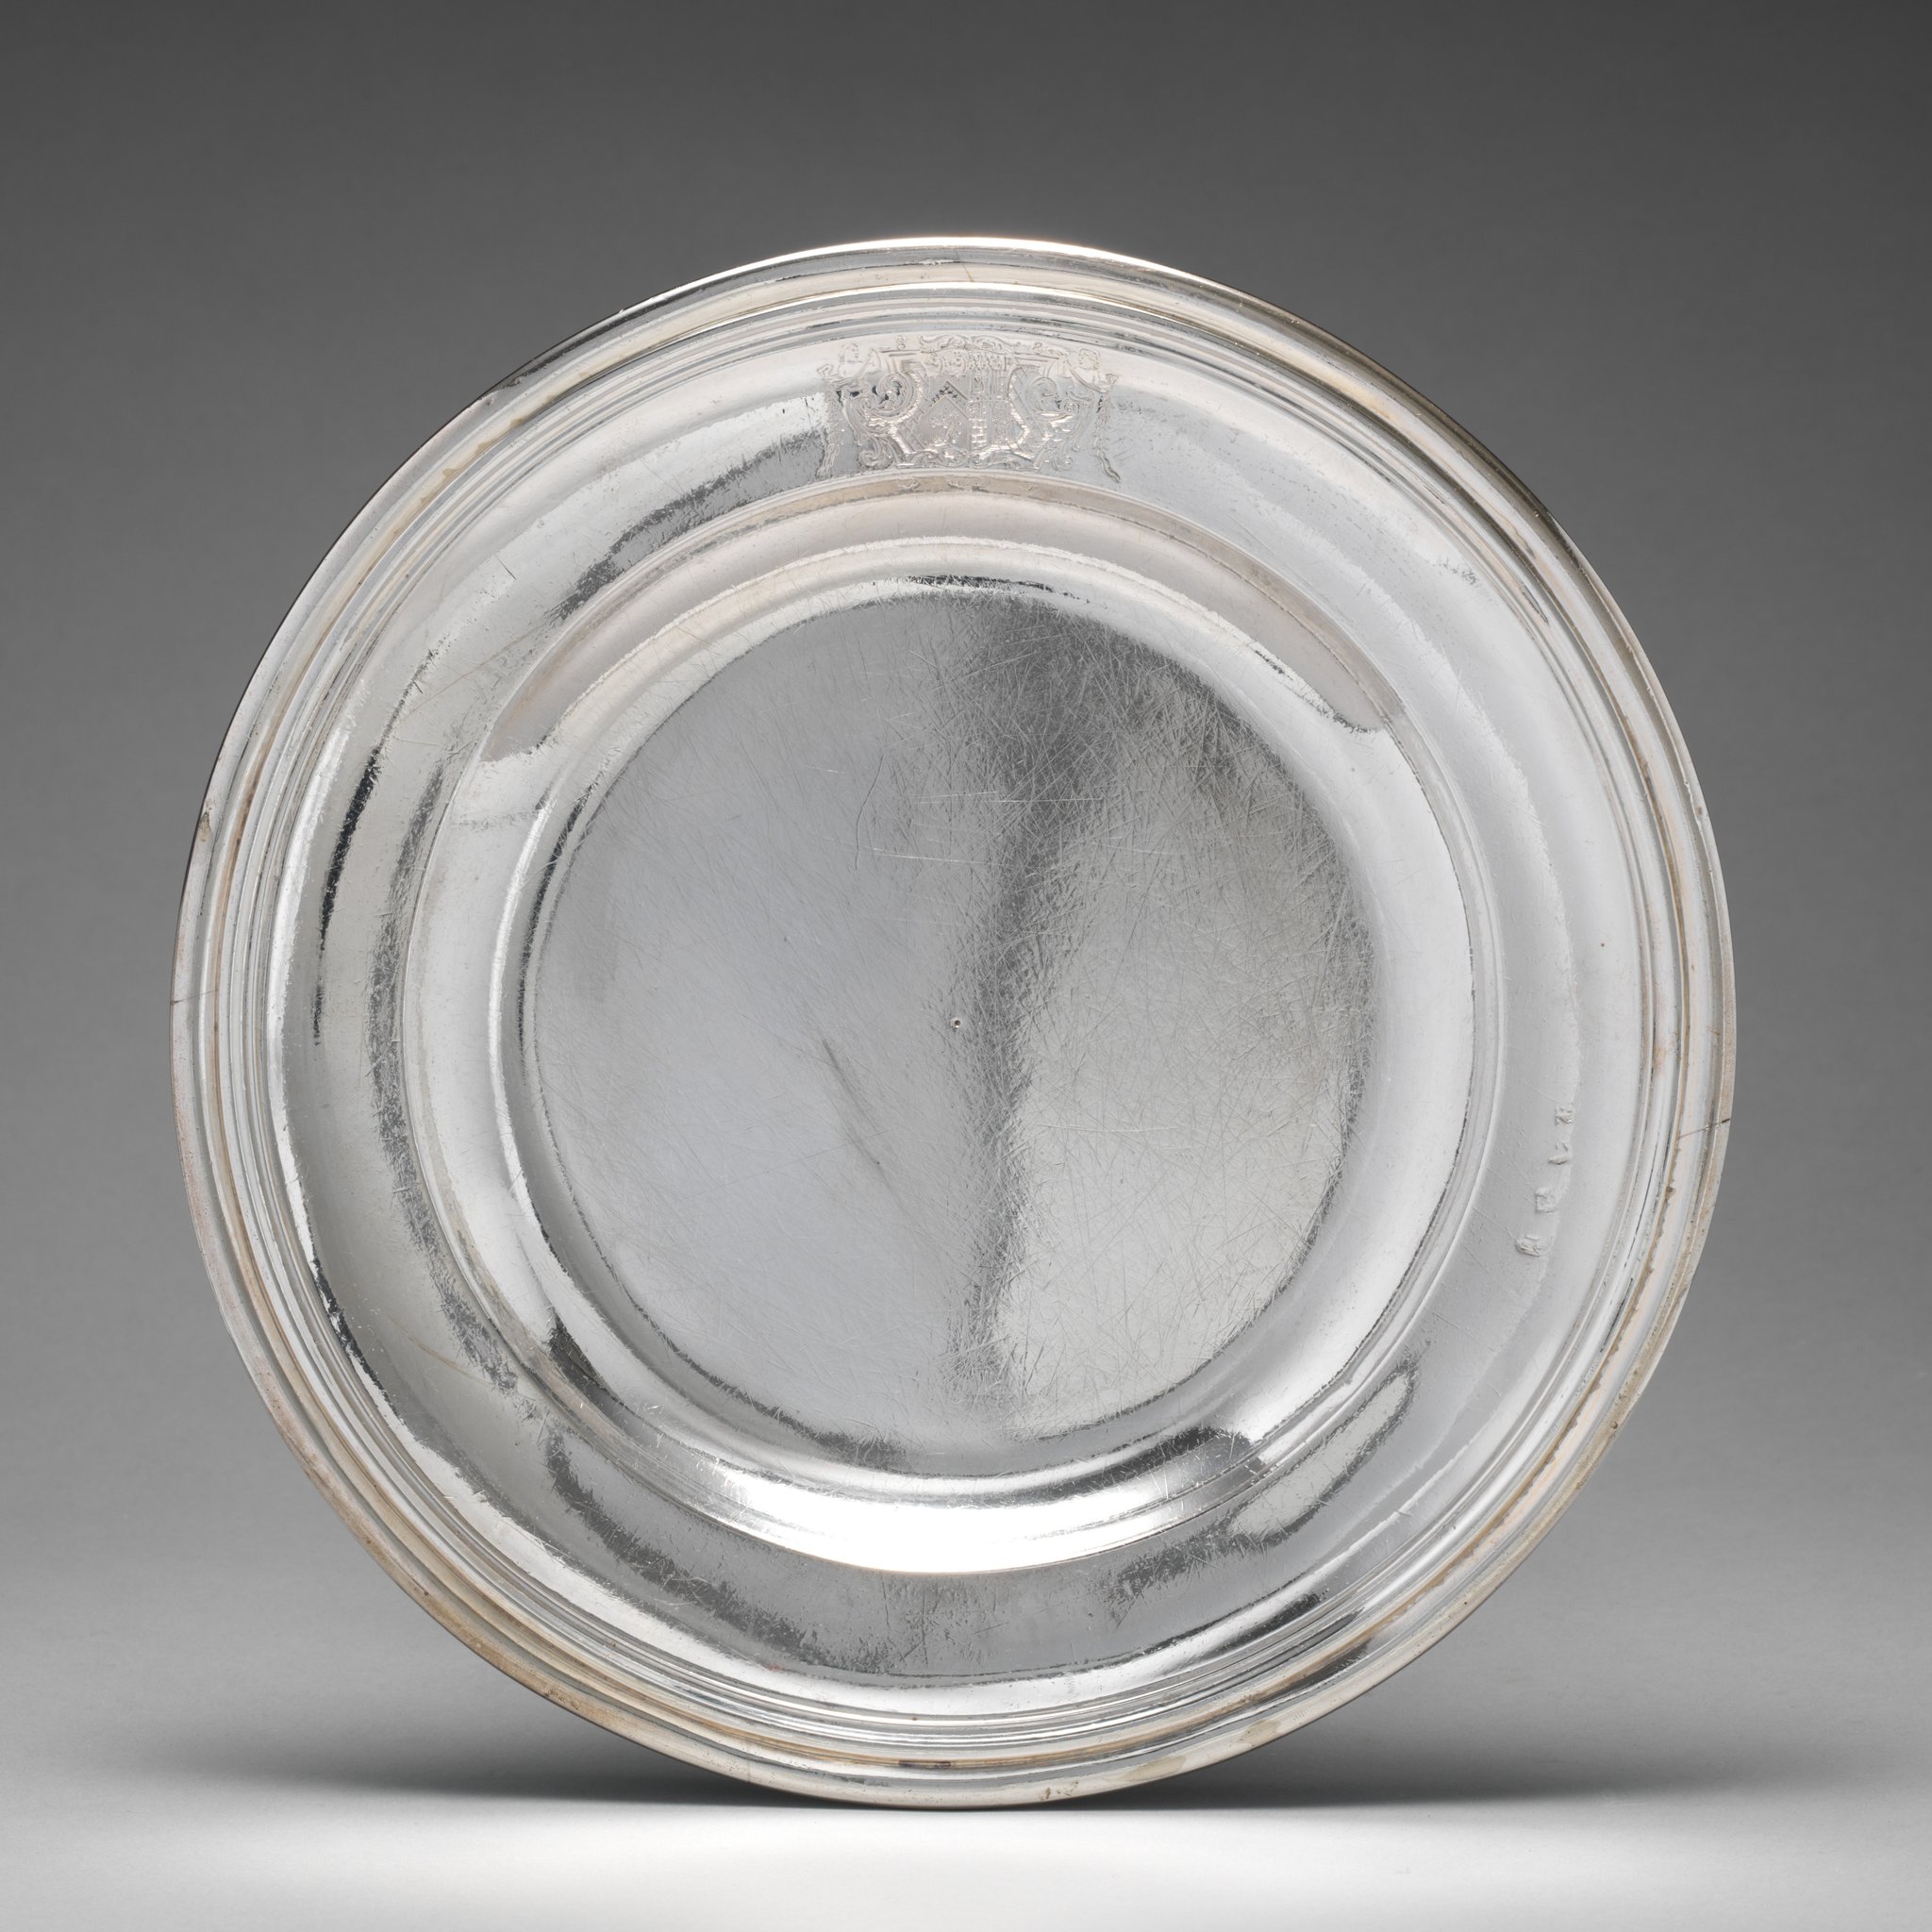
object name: plate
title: Dinner plate with English arms (one of a group of four)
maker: richard bayley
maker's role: maker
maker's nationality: british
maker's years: 1708-1748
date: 1715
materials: silver